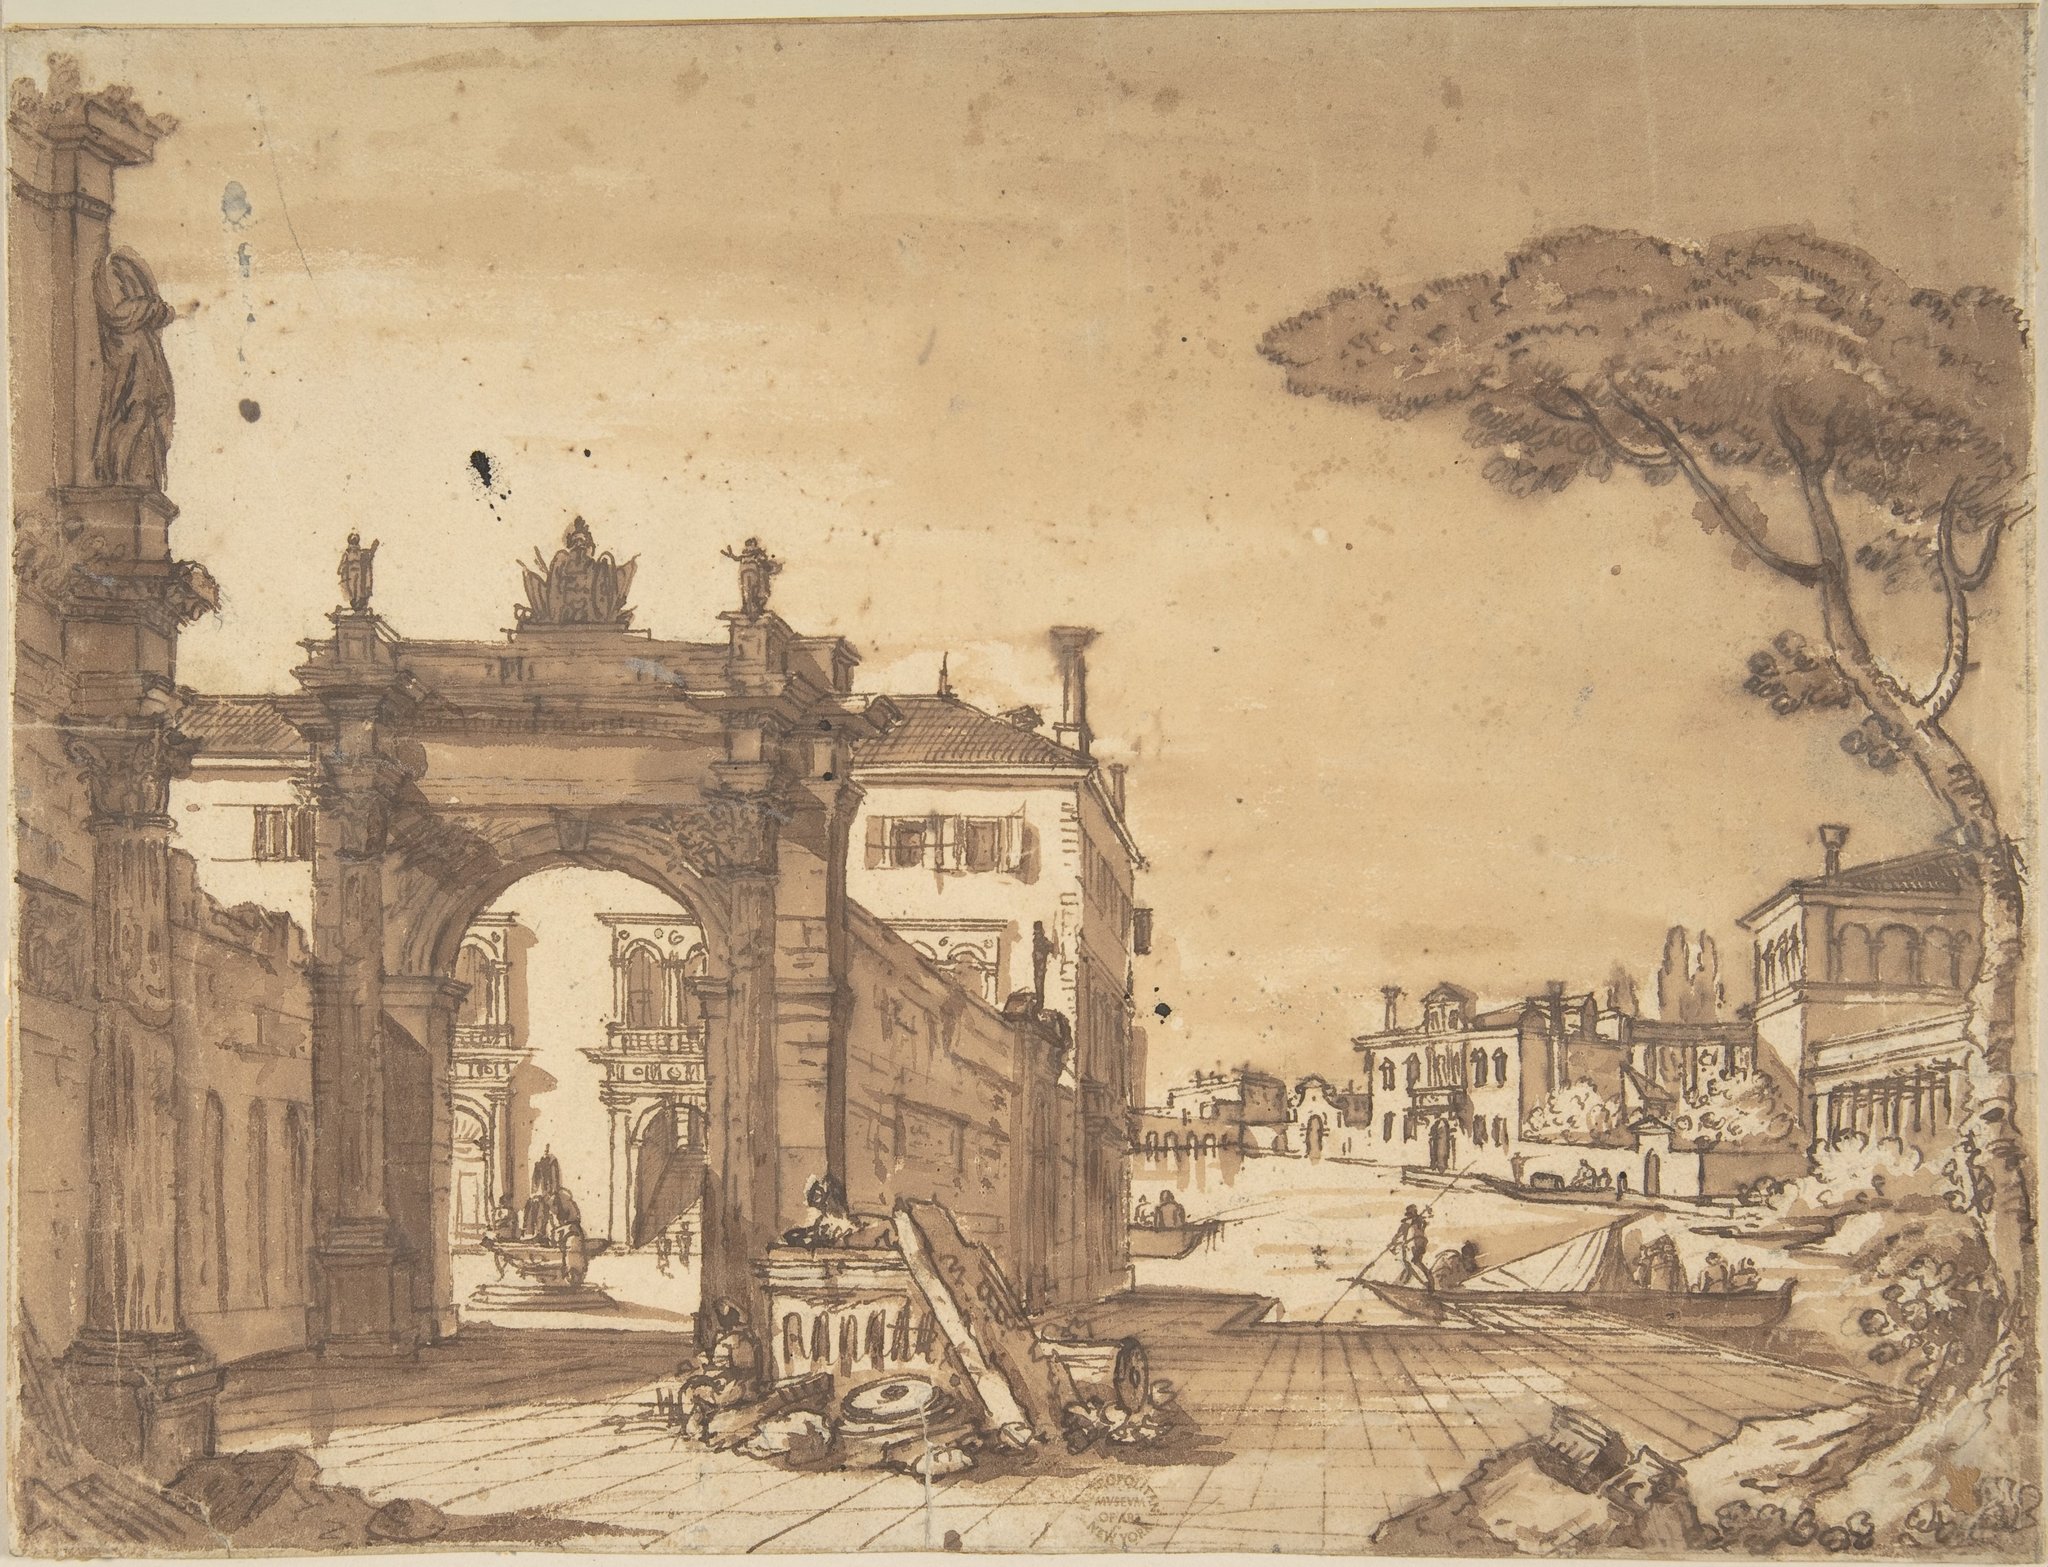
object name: drawing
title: Venetian scene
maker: anonymous, italian, 18th century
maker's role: artist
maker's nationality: italian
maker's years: 1700-1800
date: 1701-1800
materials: ink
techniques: pen, wash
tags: buildings,boats,venice